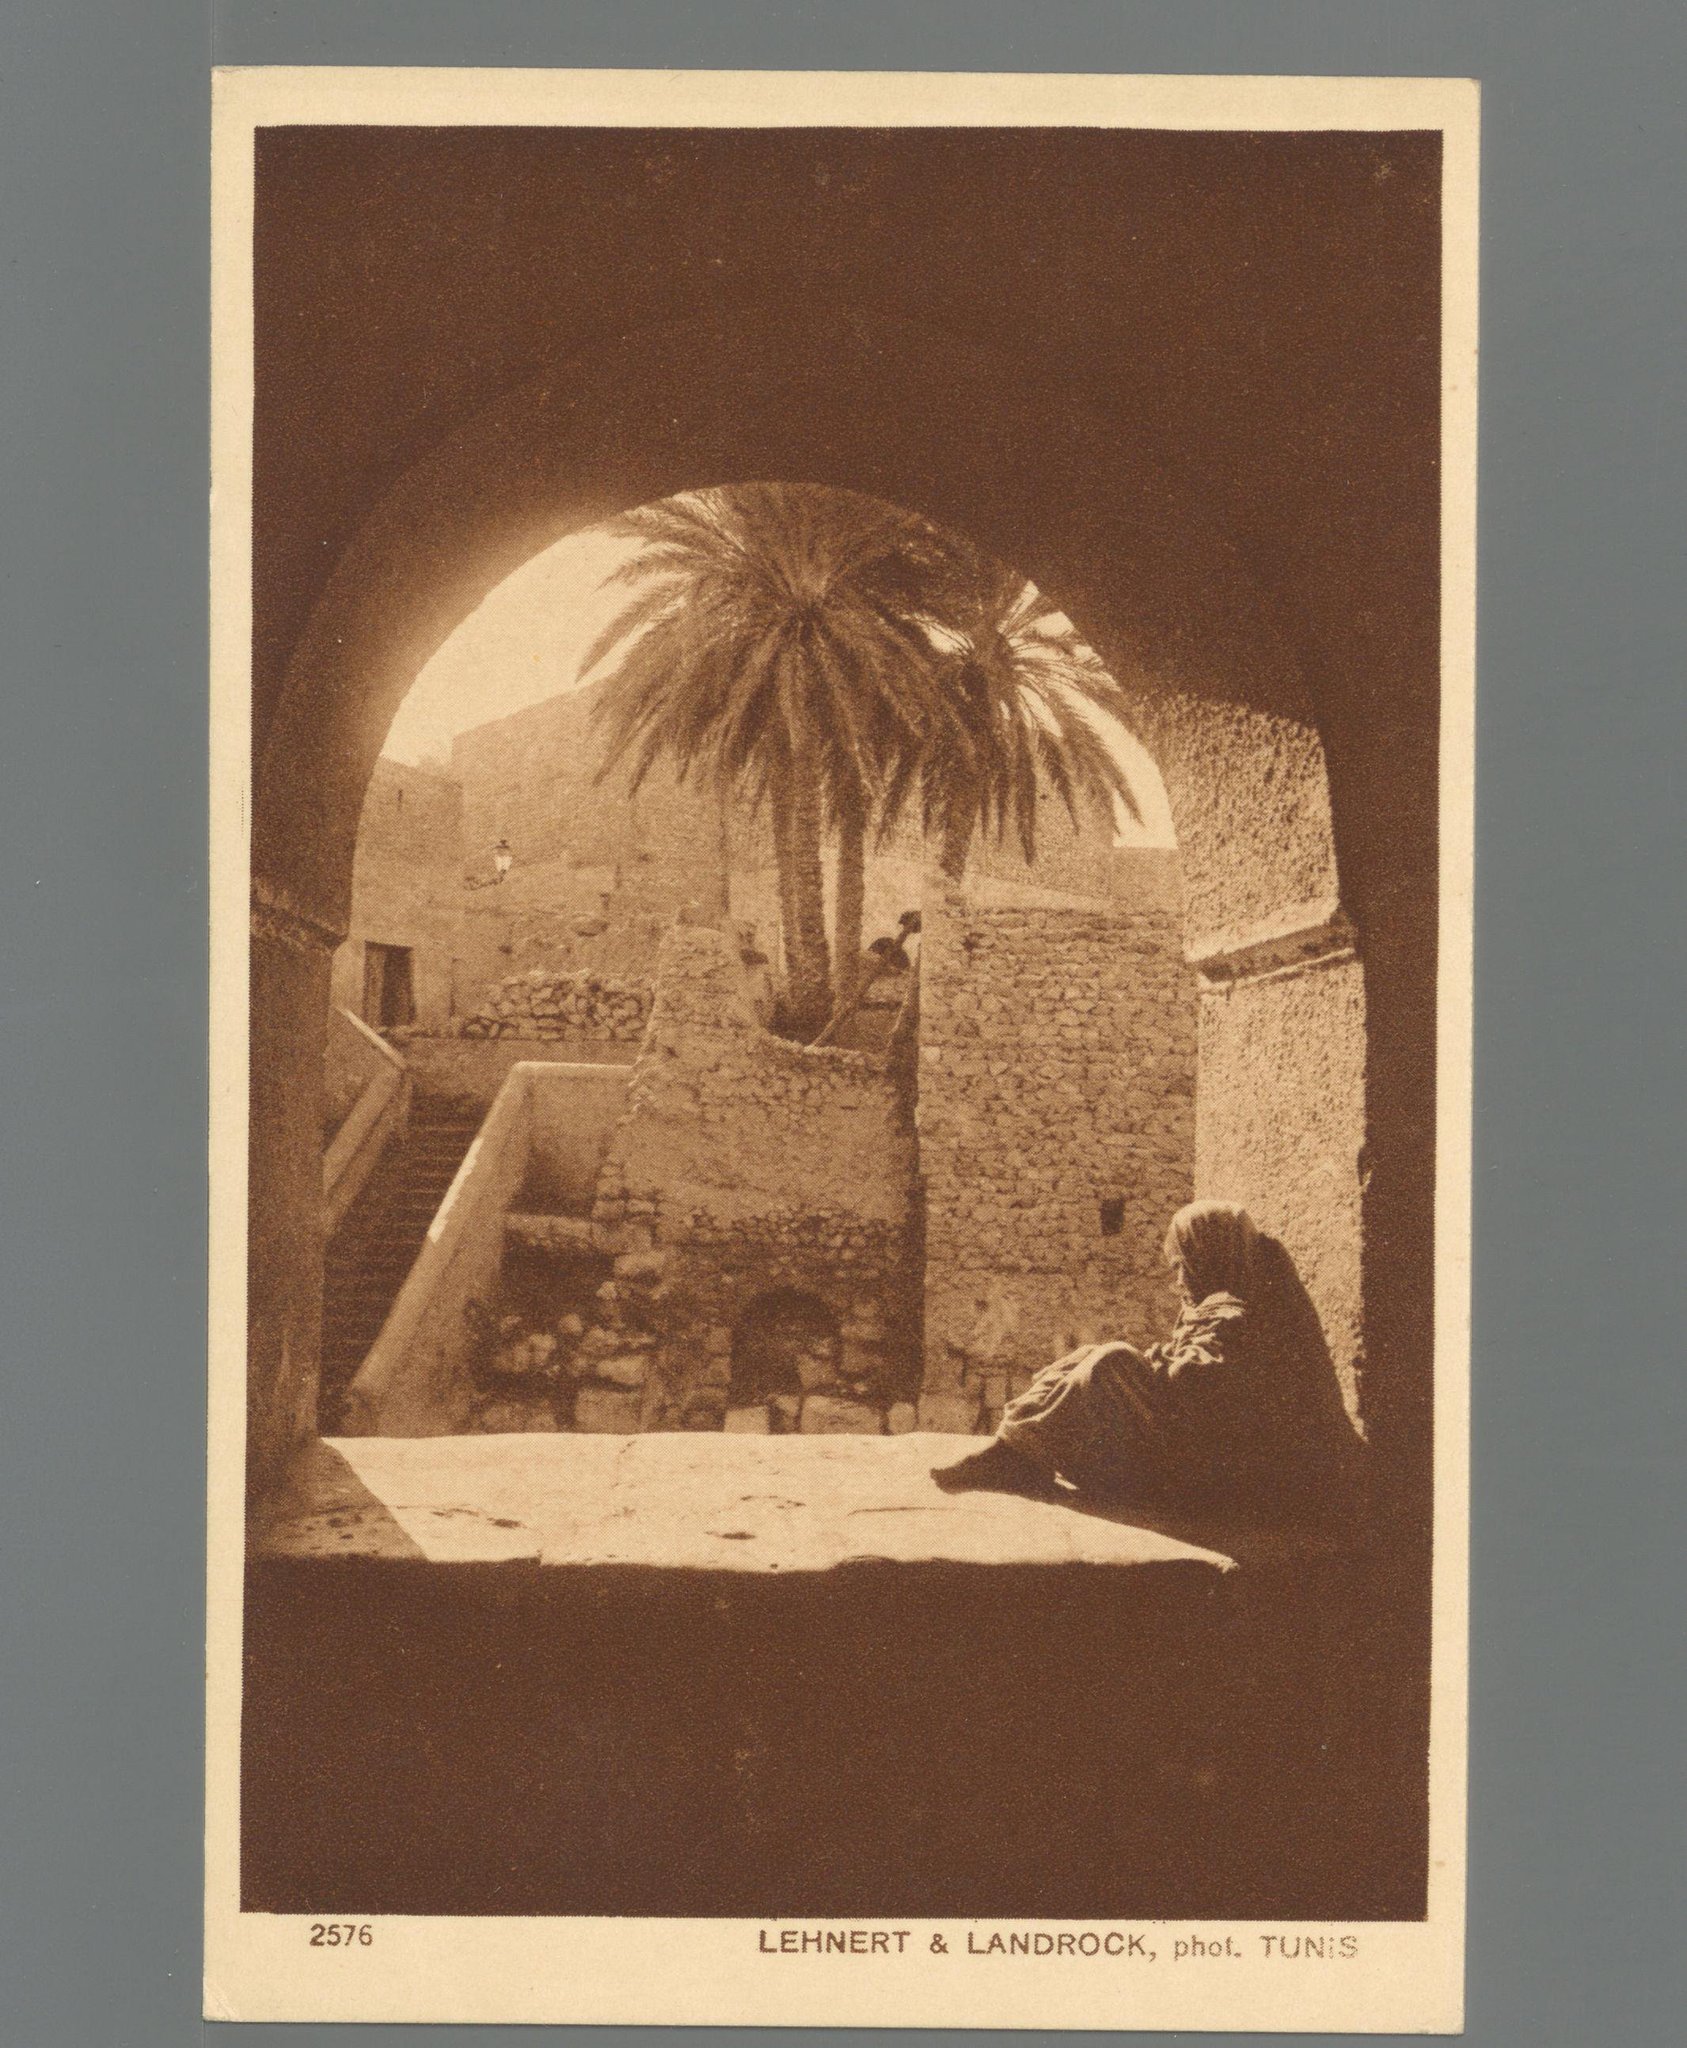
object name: photomechanical print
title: Au village arabe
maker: Anonymous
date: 1903-1930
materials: cardboard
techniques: rotogravure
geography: tunisia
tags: view through a window, village